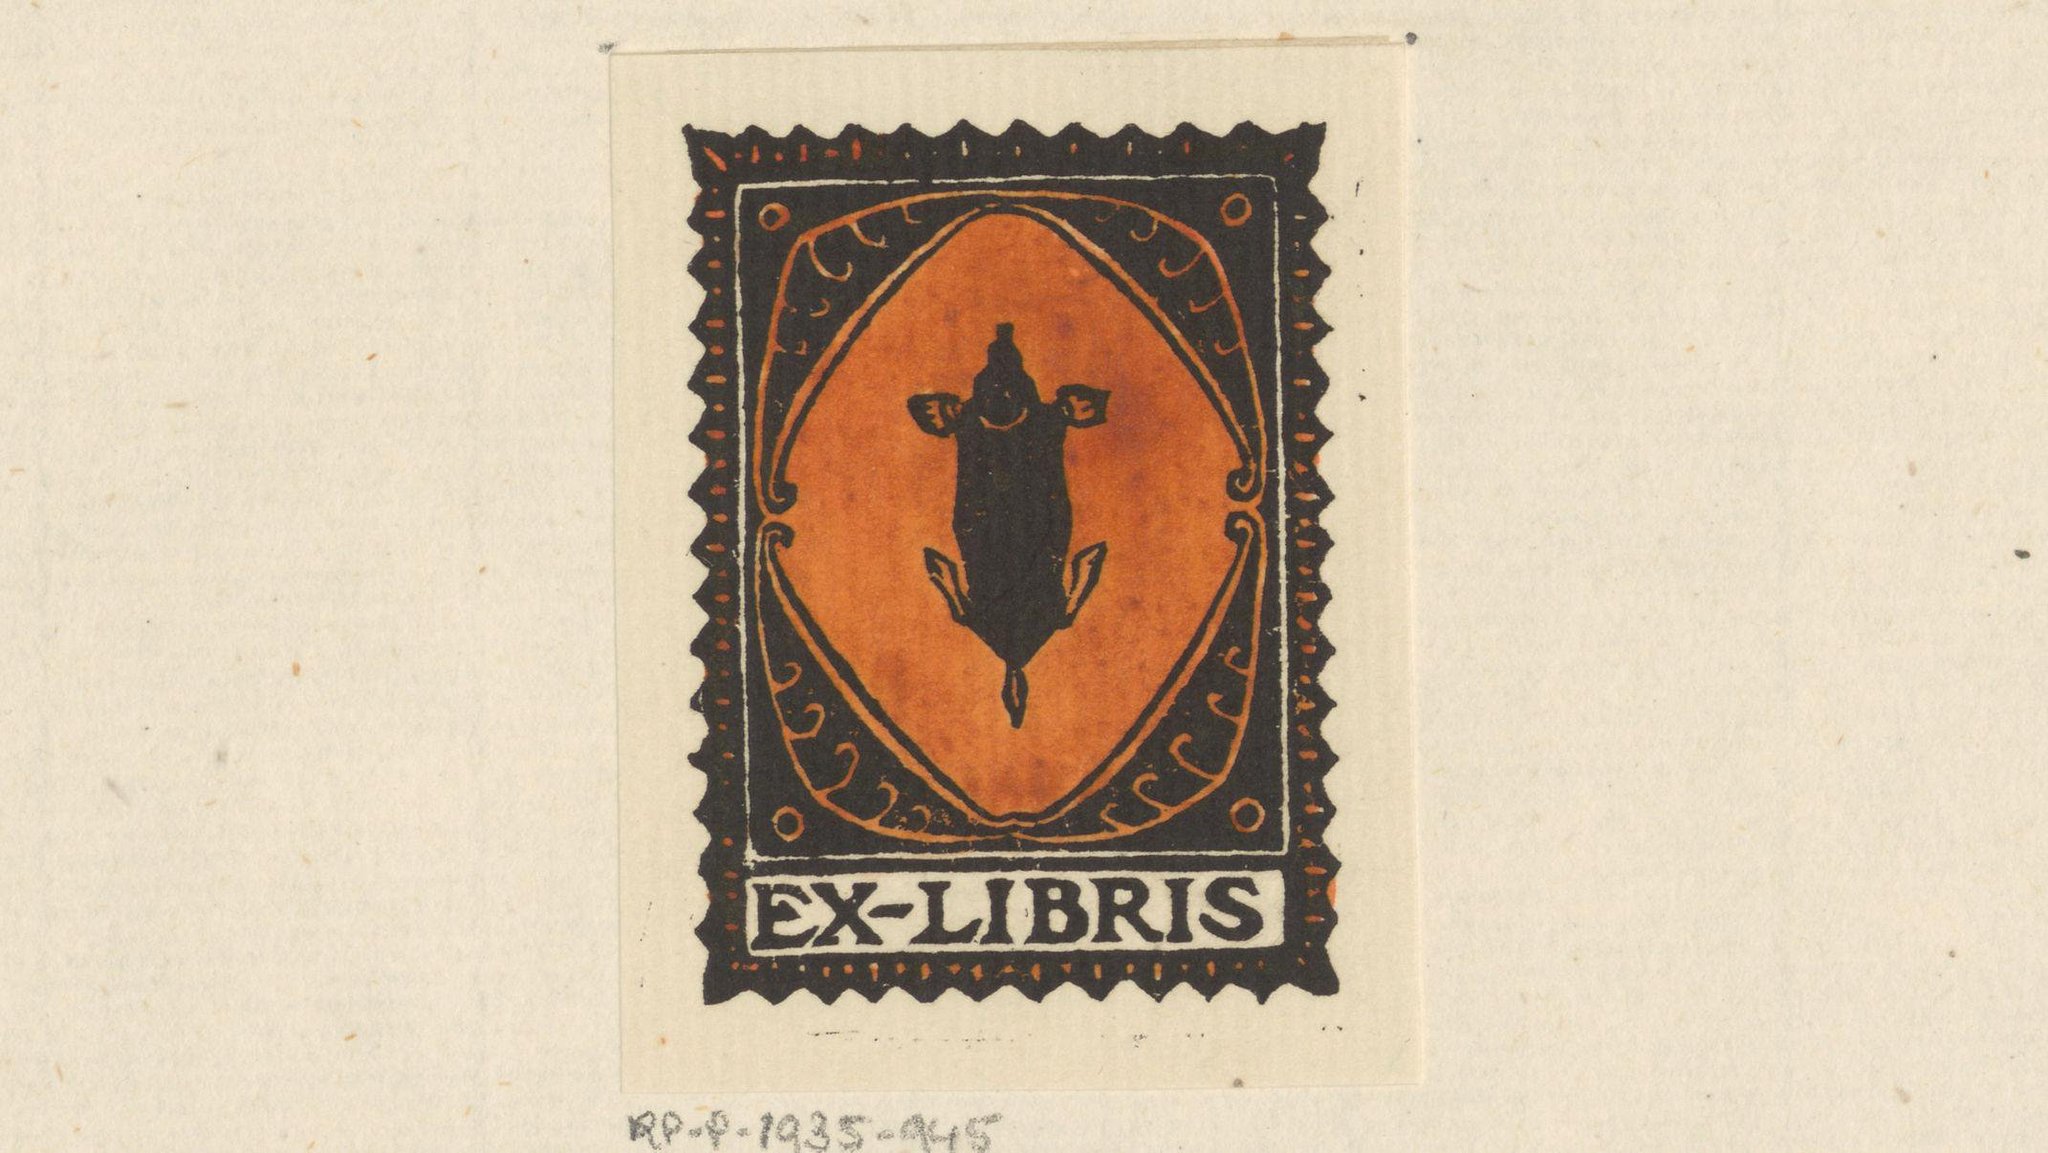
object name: bookplate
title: Ex libris van E.O. de Mol van Otterloo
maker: julie de graag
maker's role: draughtsman, print maker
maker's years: 1877-1924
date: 1917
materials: paper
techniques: hand coloring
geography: netherlands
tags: other mammals: mole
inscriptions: collector's mark: Lugt 2228